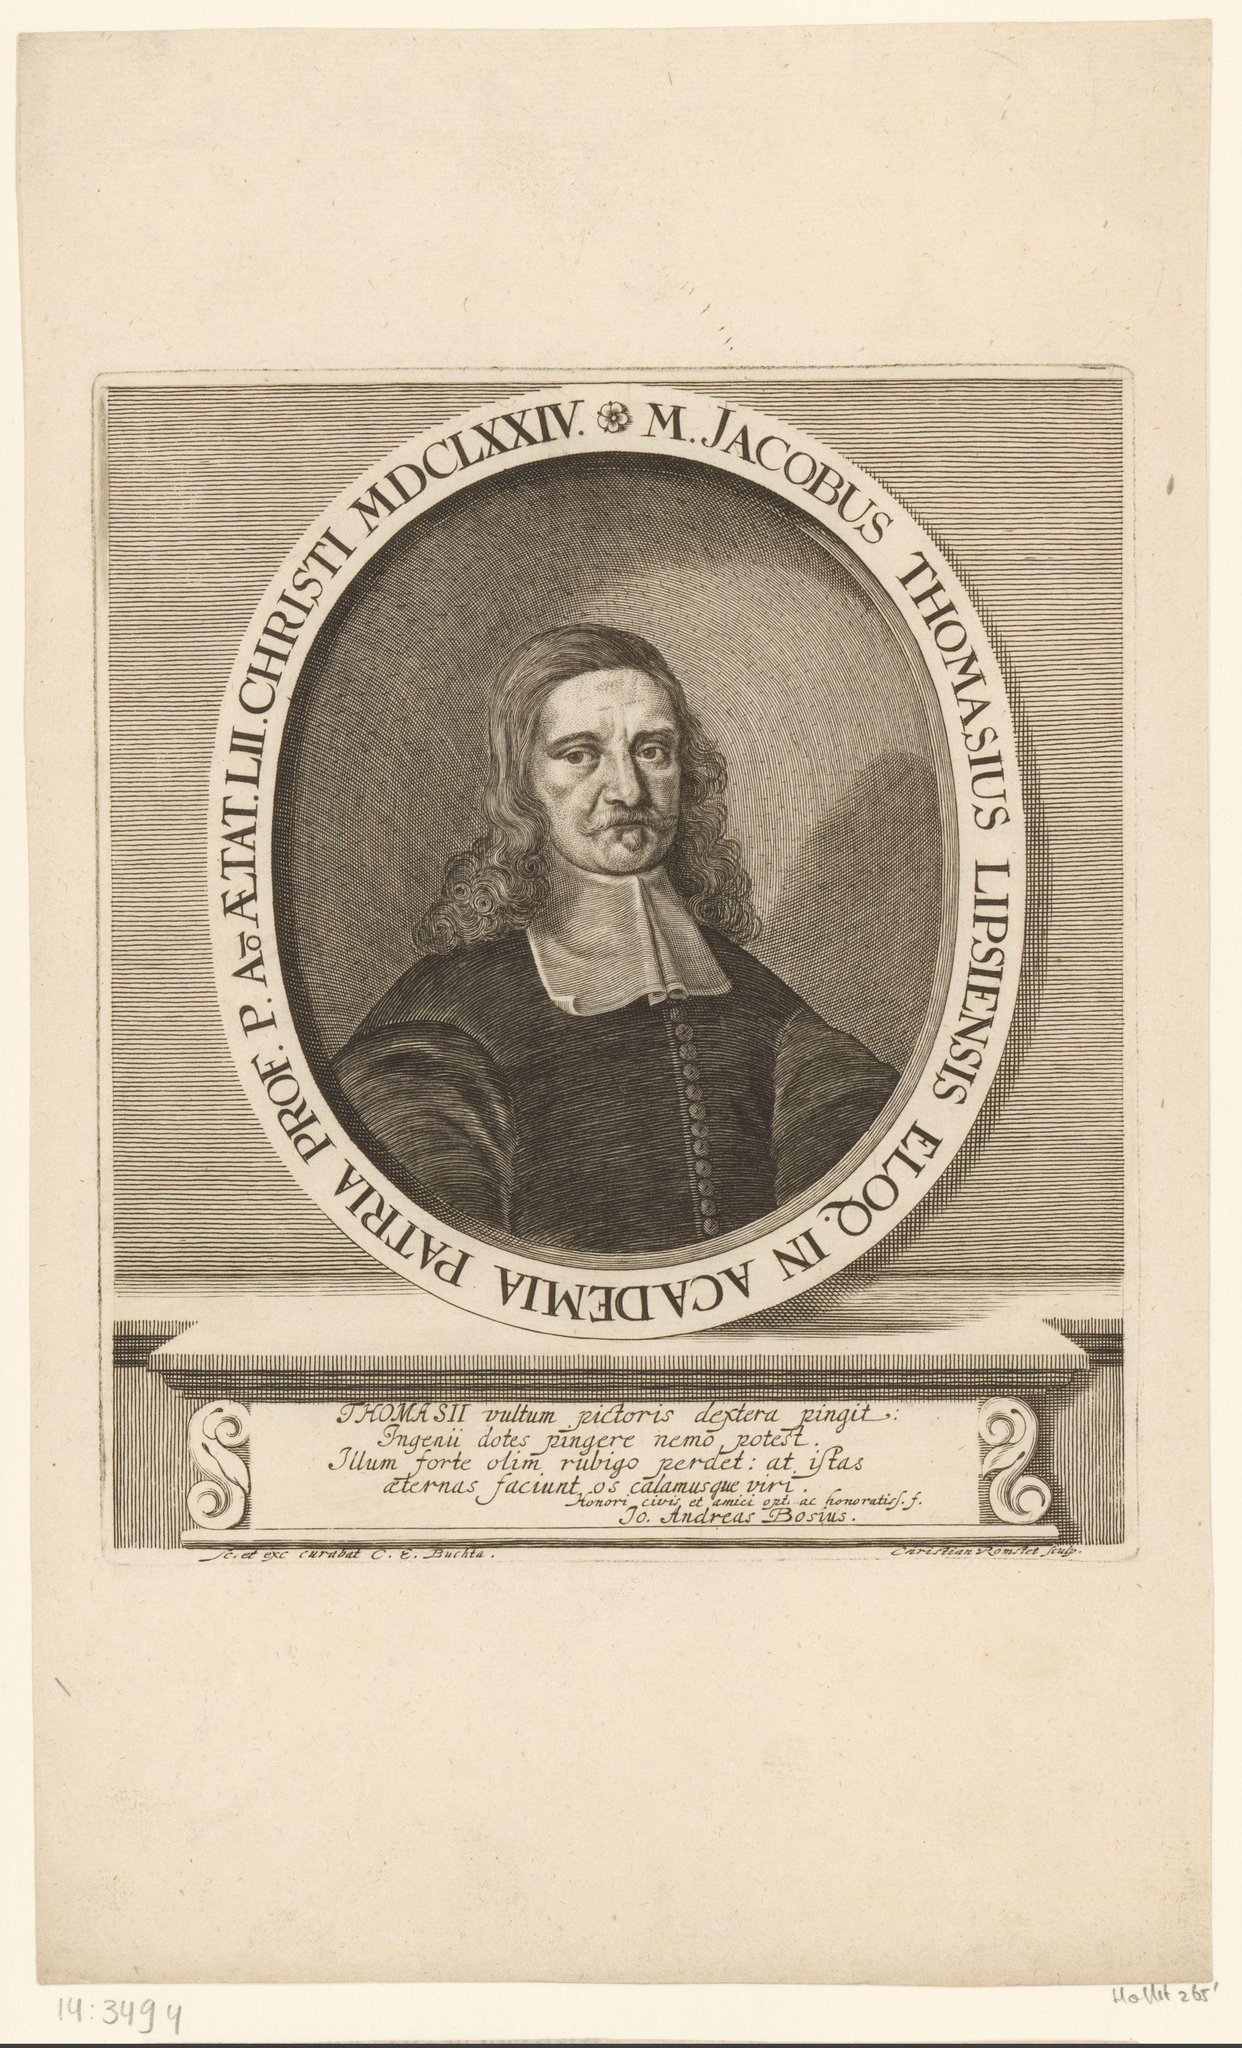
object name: print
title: Portret van Jacob Thomasius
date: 1665-1721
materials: paper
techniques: engraving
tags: jacob thomasius, historical persons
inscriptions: collector's mark: Lugt 2228